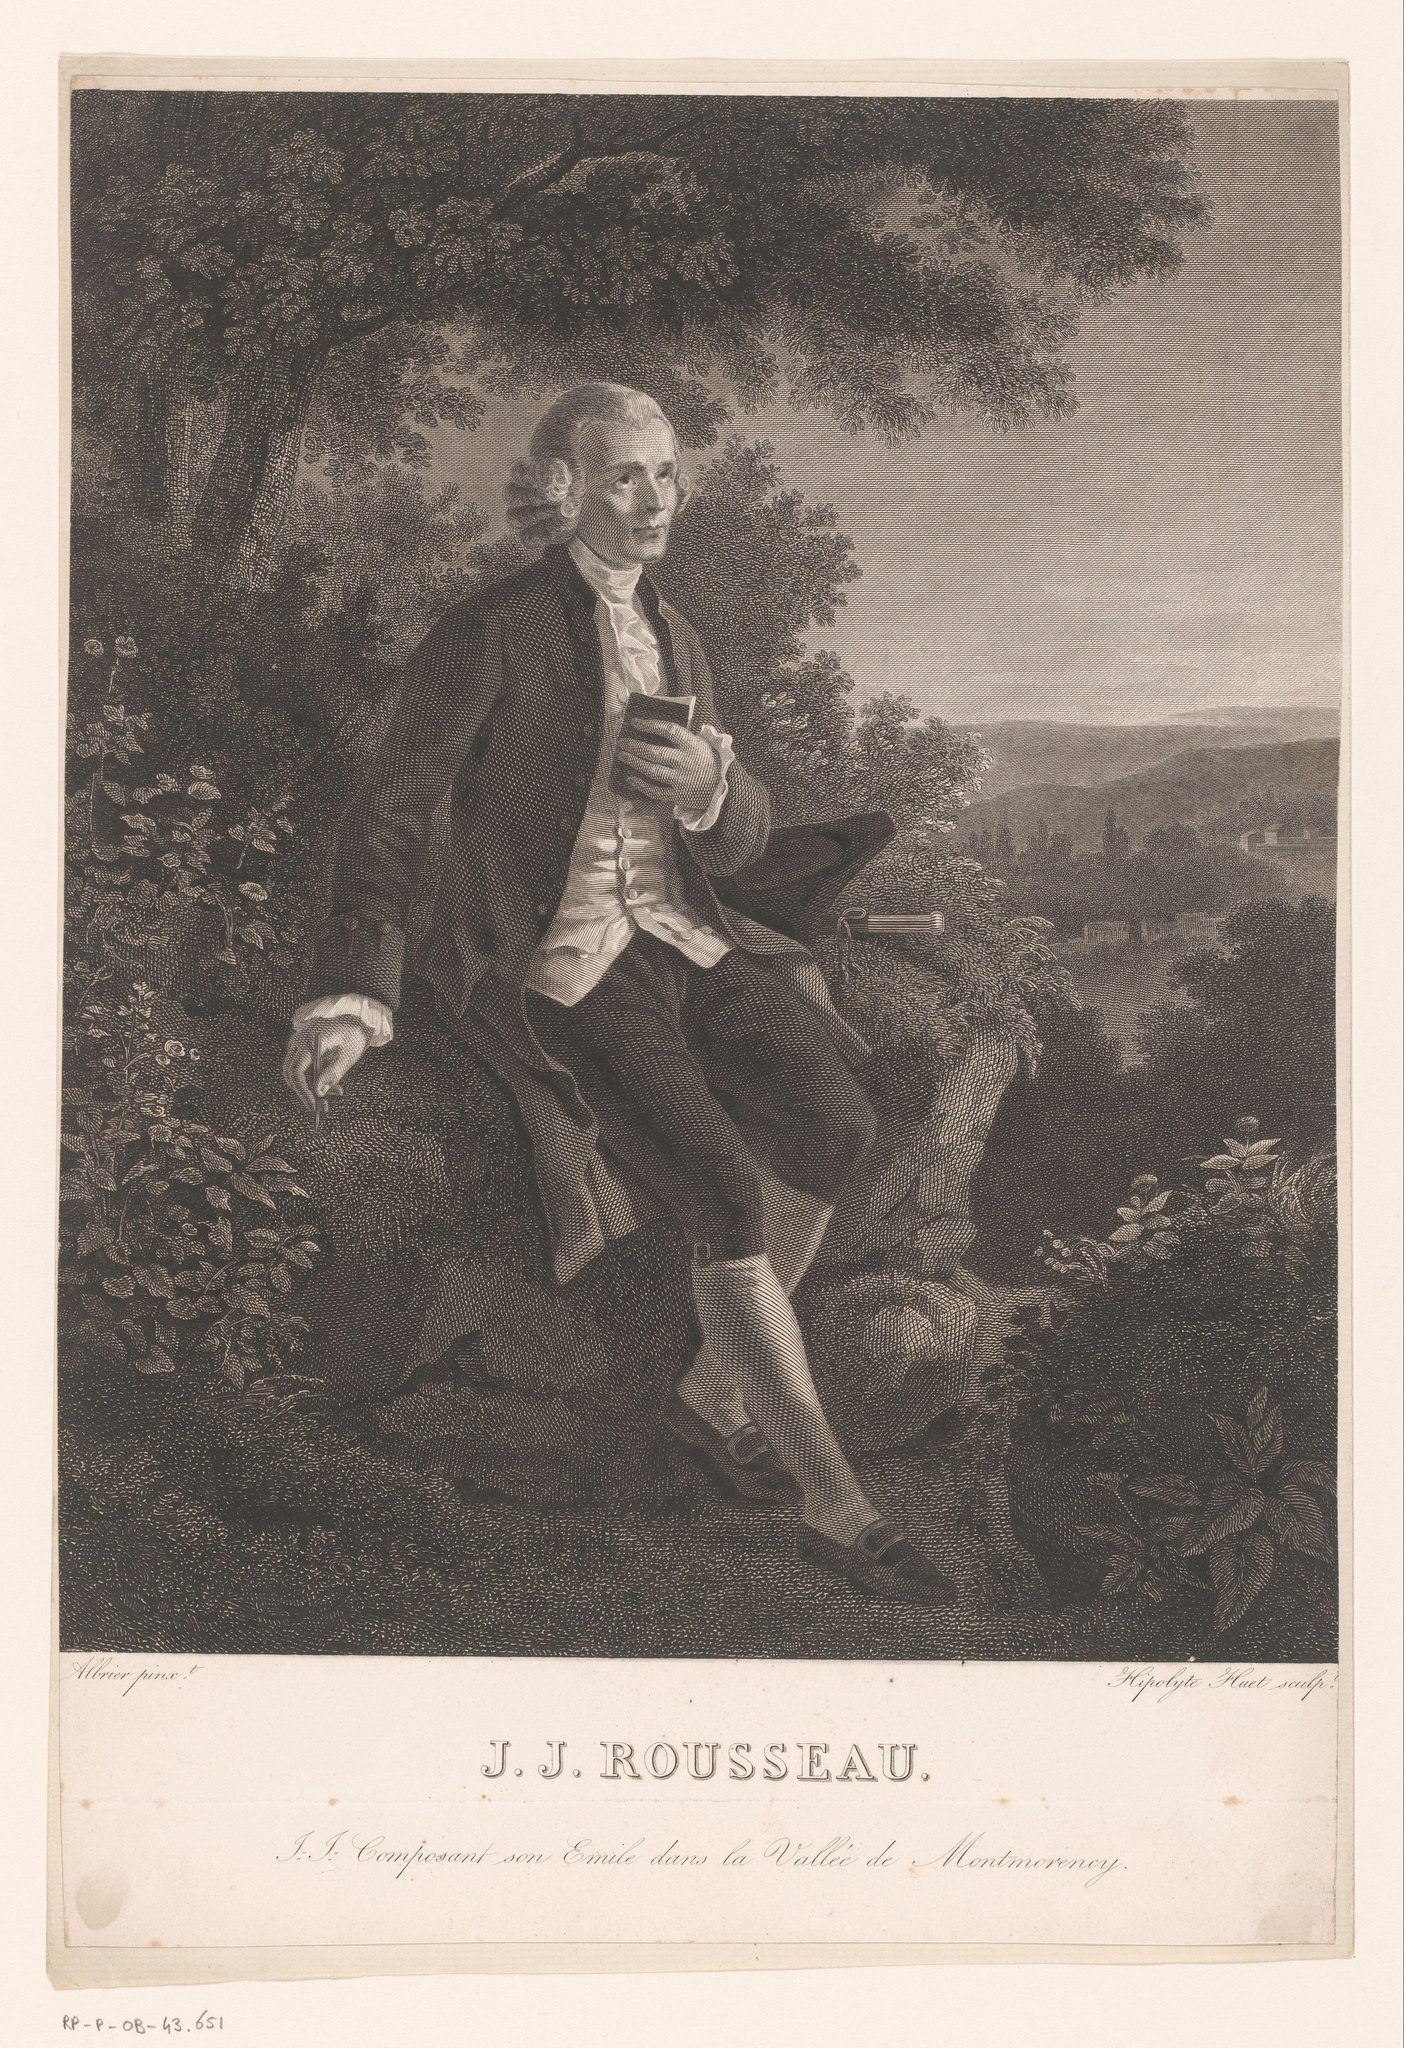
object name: print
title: Portret van Jean-Jacques Rousseau, gezeten op een rots in een landschap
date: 1824-1835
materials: paper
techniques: engraving, etching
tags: scholar, philosopher, historical persons, portrait of a writer